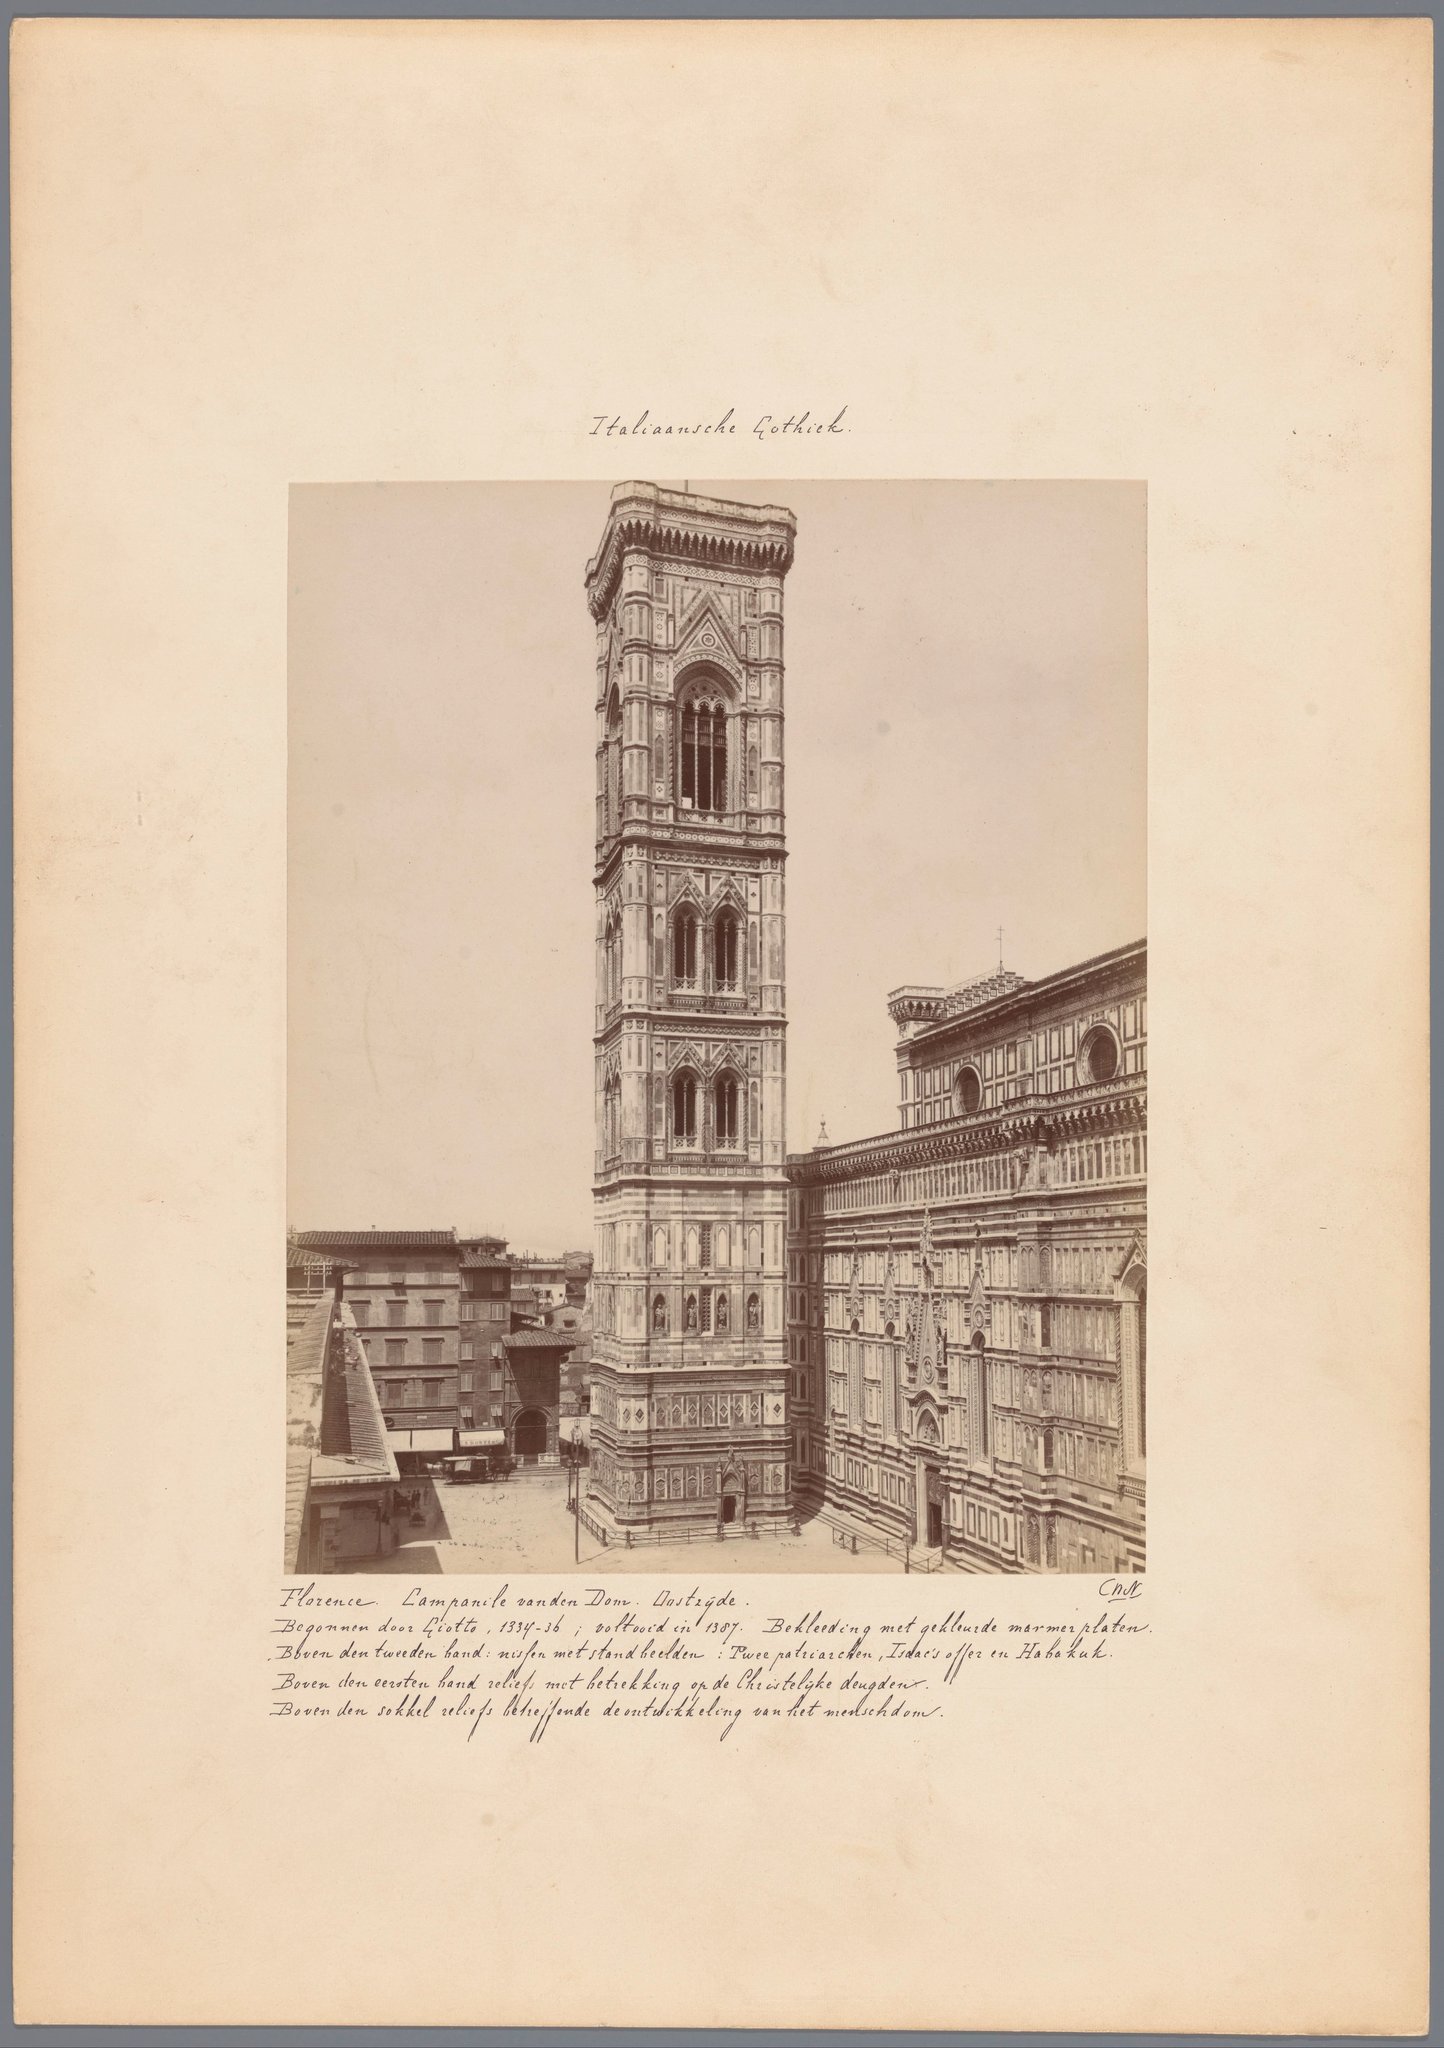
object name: photograph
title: Florence. Campanile van den Dom. Oostzijde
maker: Anonymous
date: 1875-1900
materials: cardboard, photographic support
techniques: albumen print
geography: florence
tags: tower, clock tower ~ monumental adornment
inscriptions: collector's mark: ‘INSTITUUT VOOR KUNST-NIJVERHEIDSONDERWIJS GABRIËL METSUSTRAAT No. 16 AMSTERDAM’, inscription: ‘Italiaansche Gothiek.’, collector's mark: ‘KUNSTNIJVERHEIDSCHOOL QUELLINUS AMSTERDAM FRANS HALSSTRAAT 14.’, inscription: ‘CWN.’